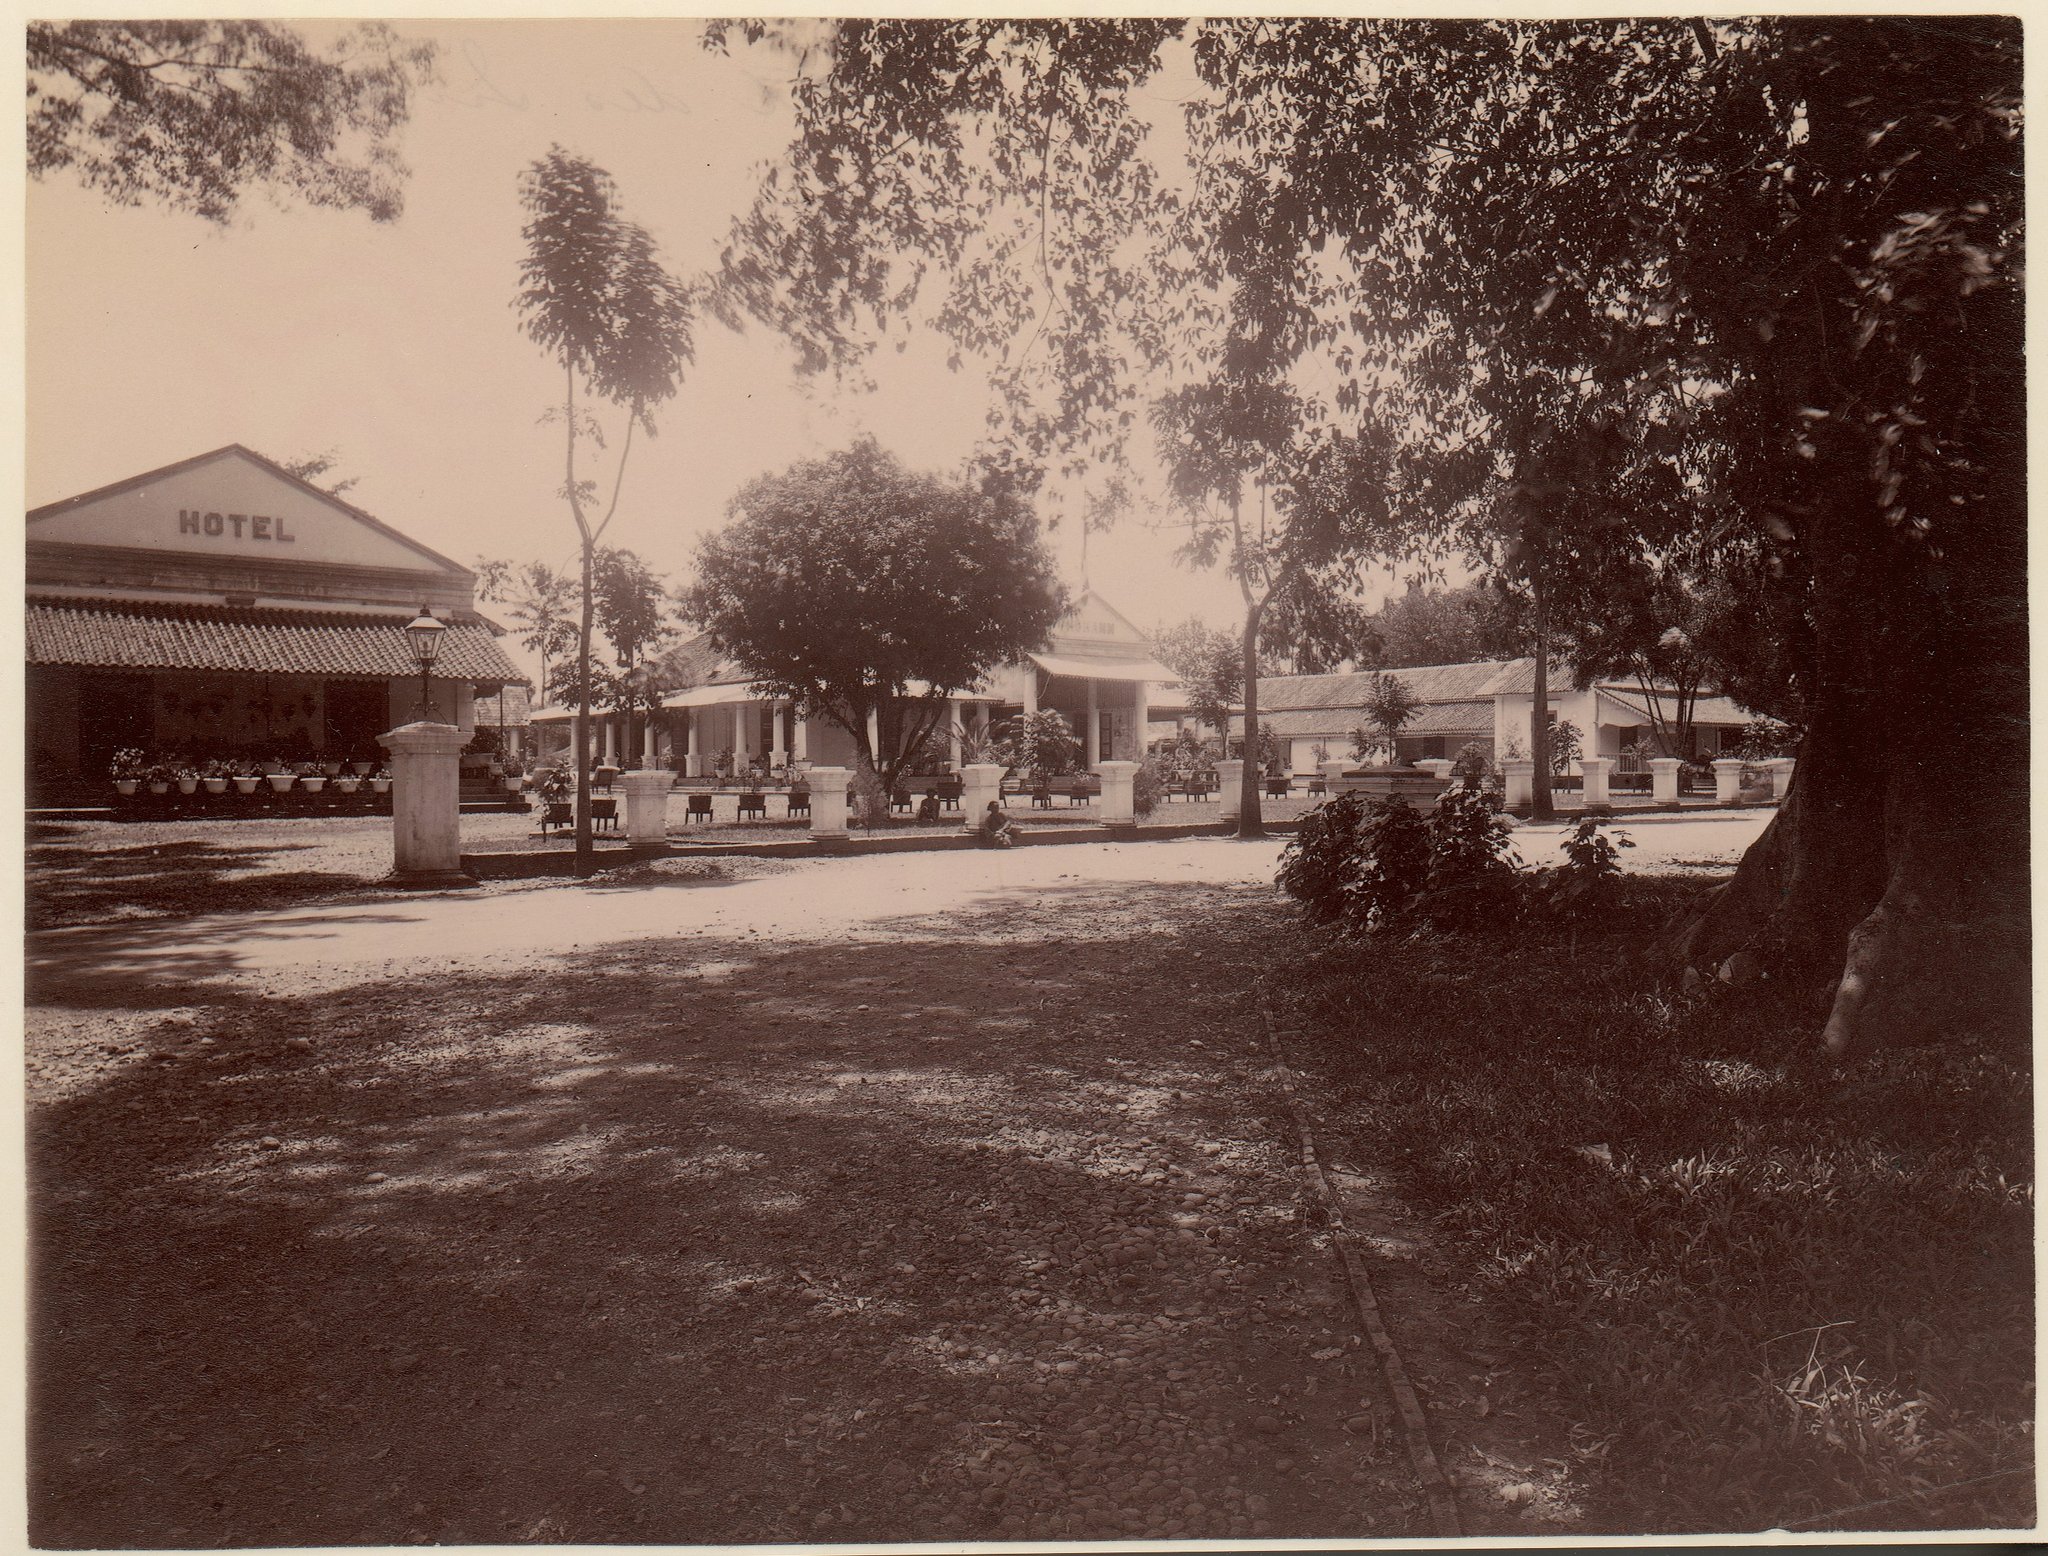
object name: photograph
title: Hotel des Indes, Batavia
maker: Anonymous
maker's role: artist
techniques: gelatin silver print, glass negative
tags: hotels